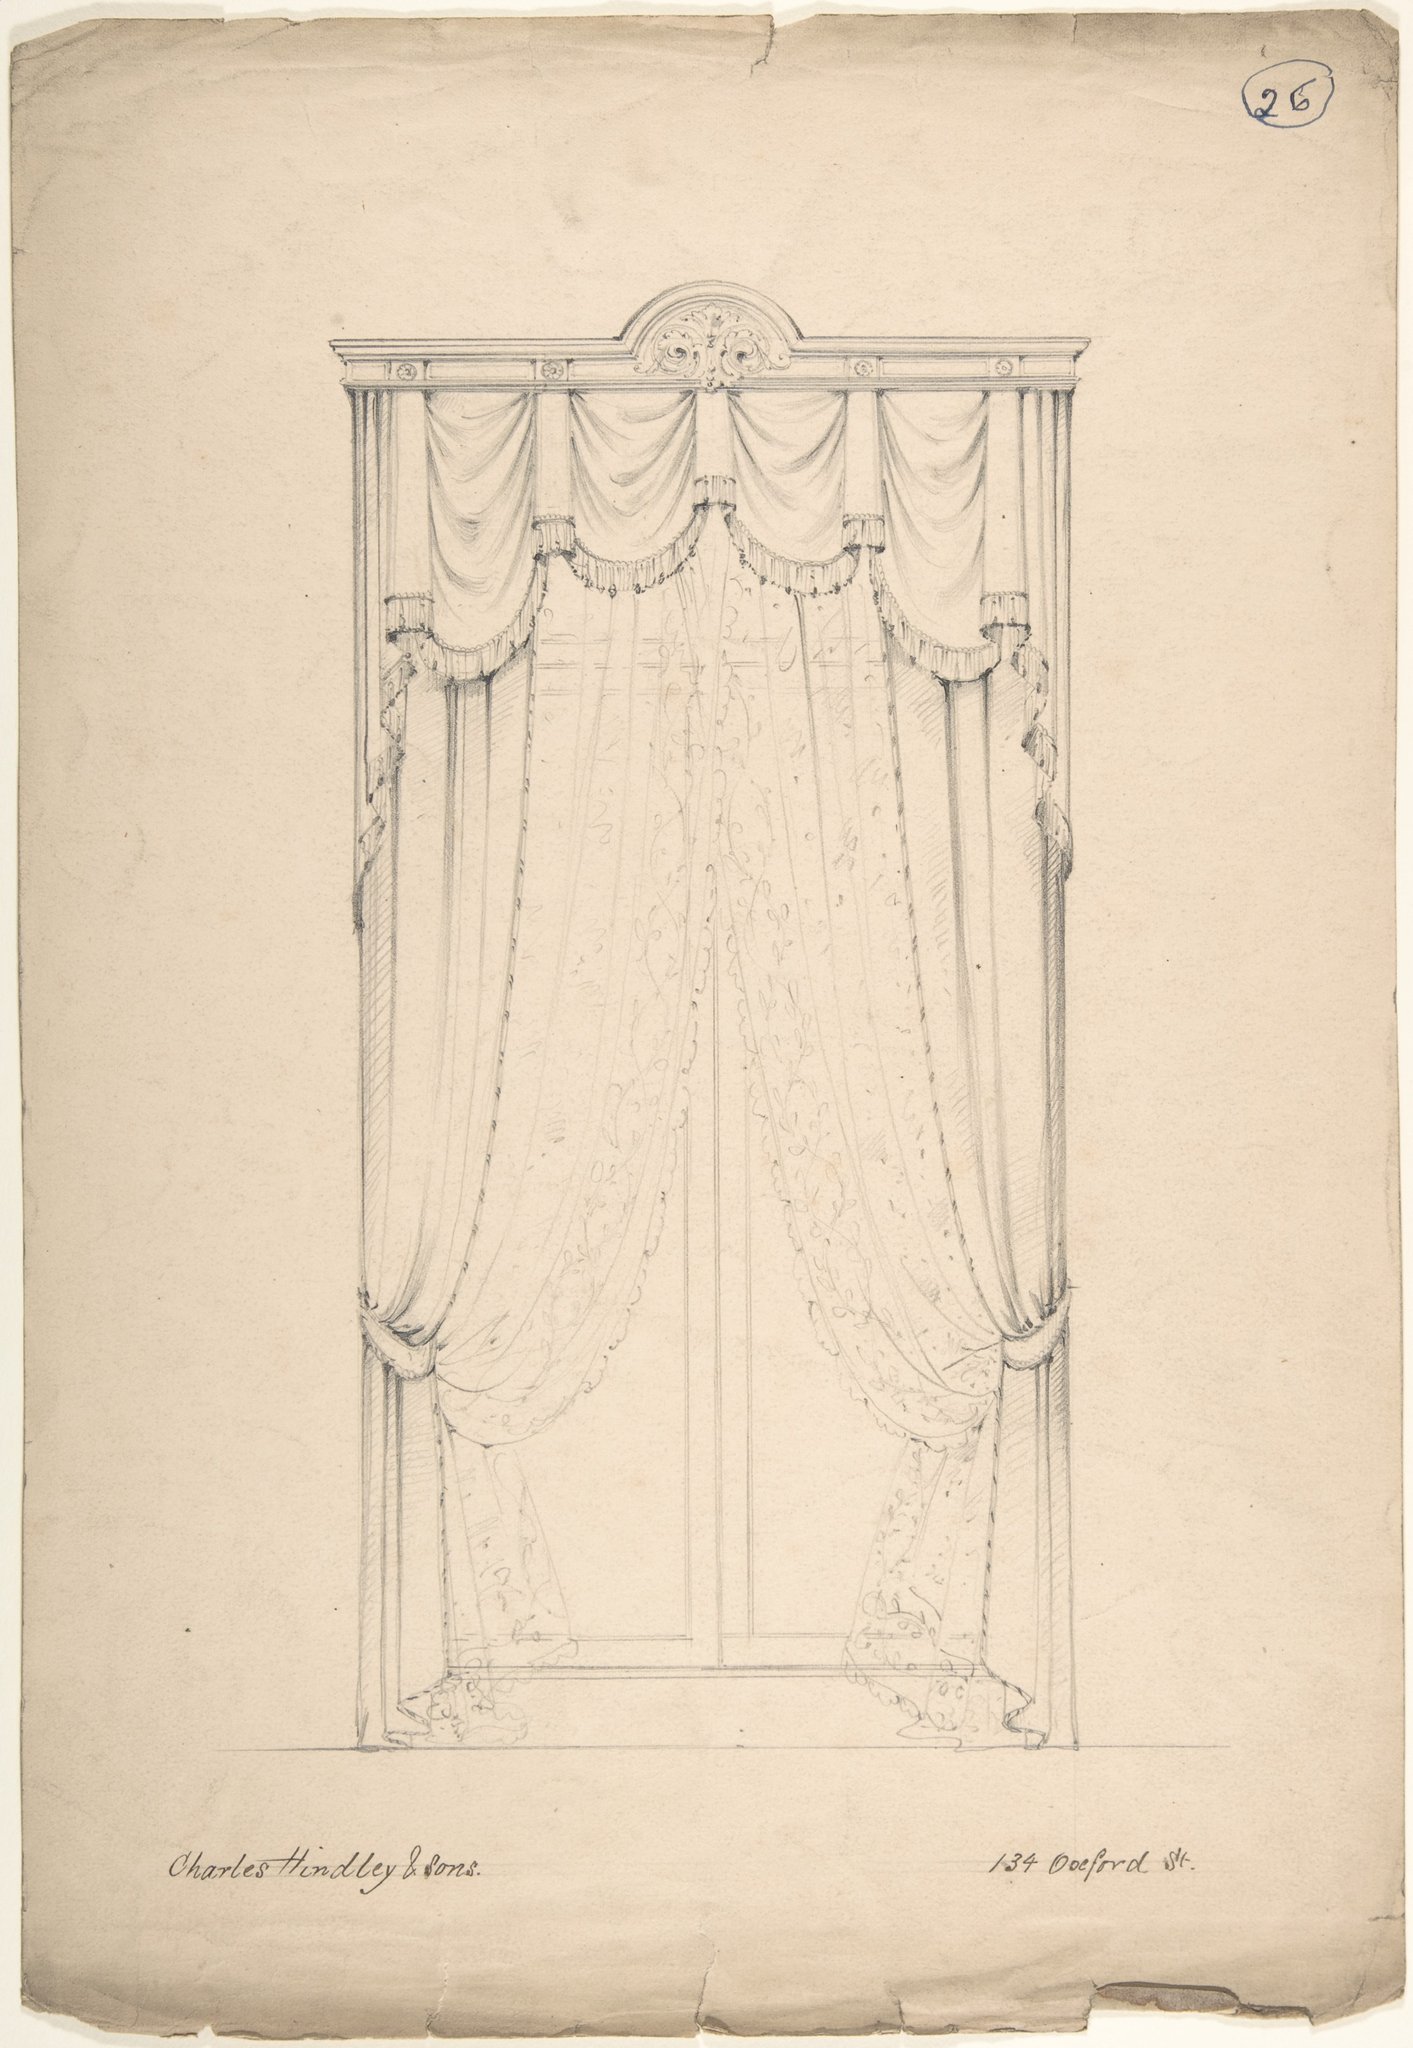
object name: drawing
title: Design for Curtains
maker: charles hindley and sons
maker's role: artist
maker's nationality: british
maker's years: 1841-1917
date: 1841-1884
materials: graphite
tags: curtains